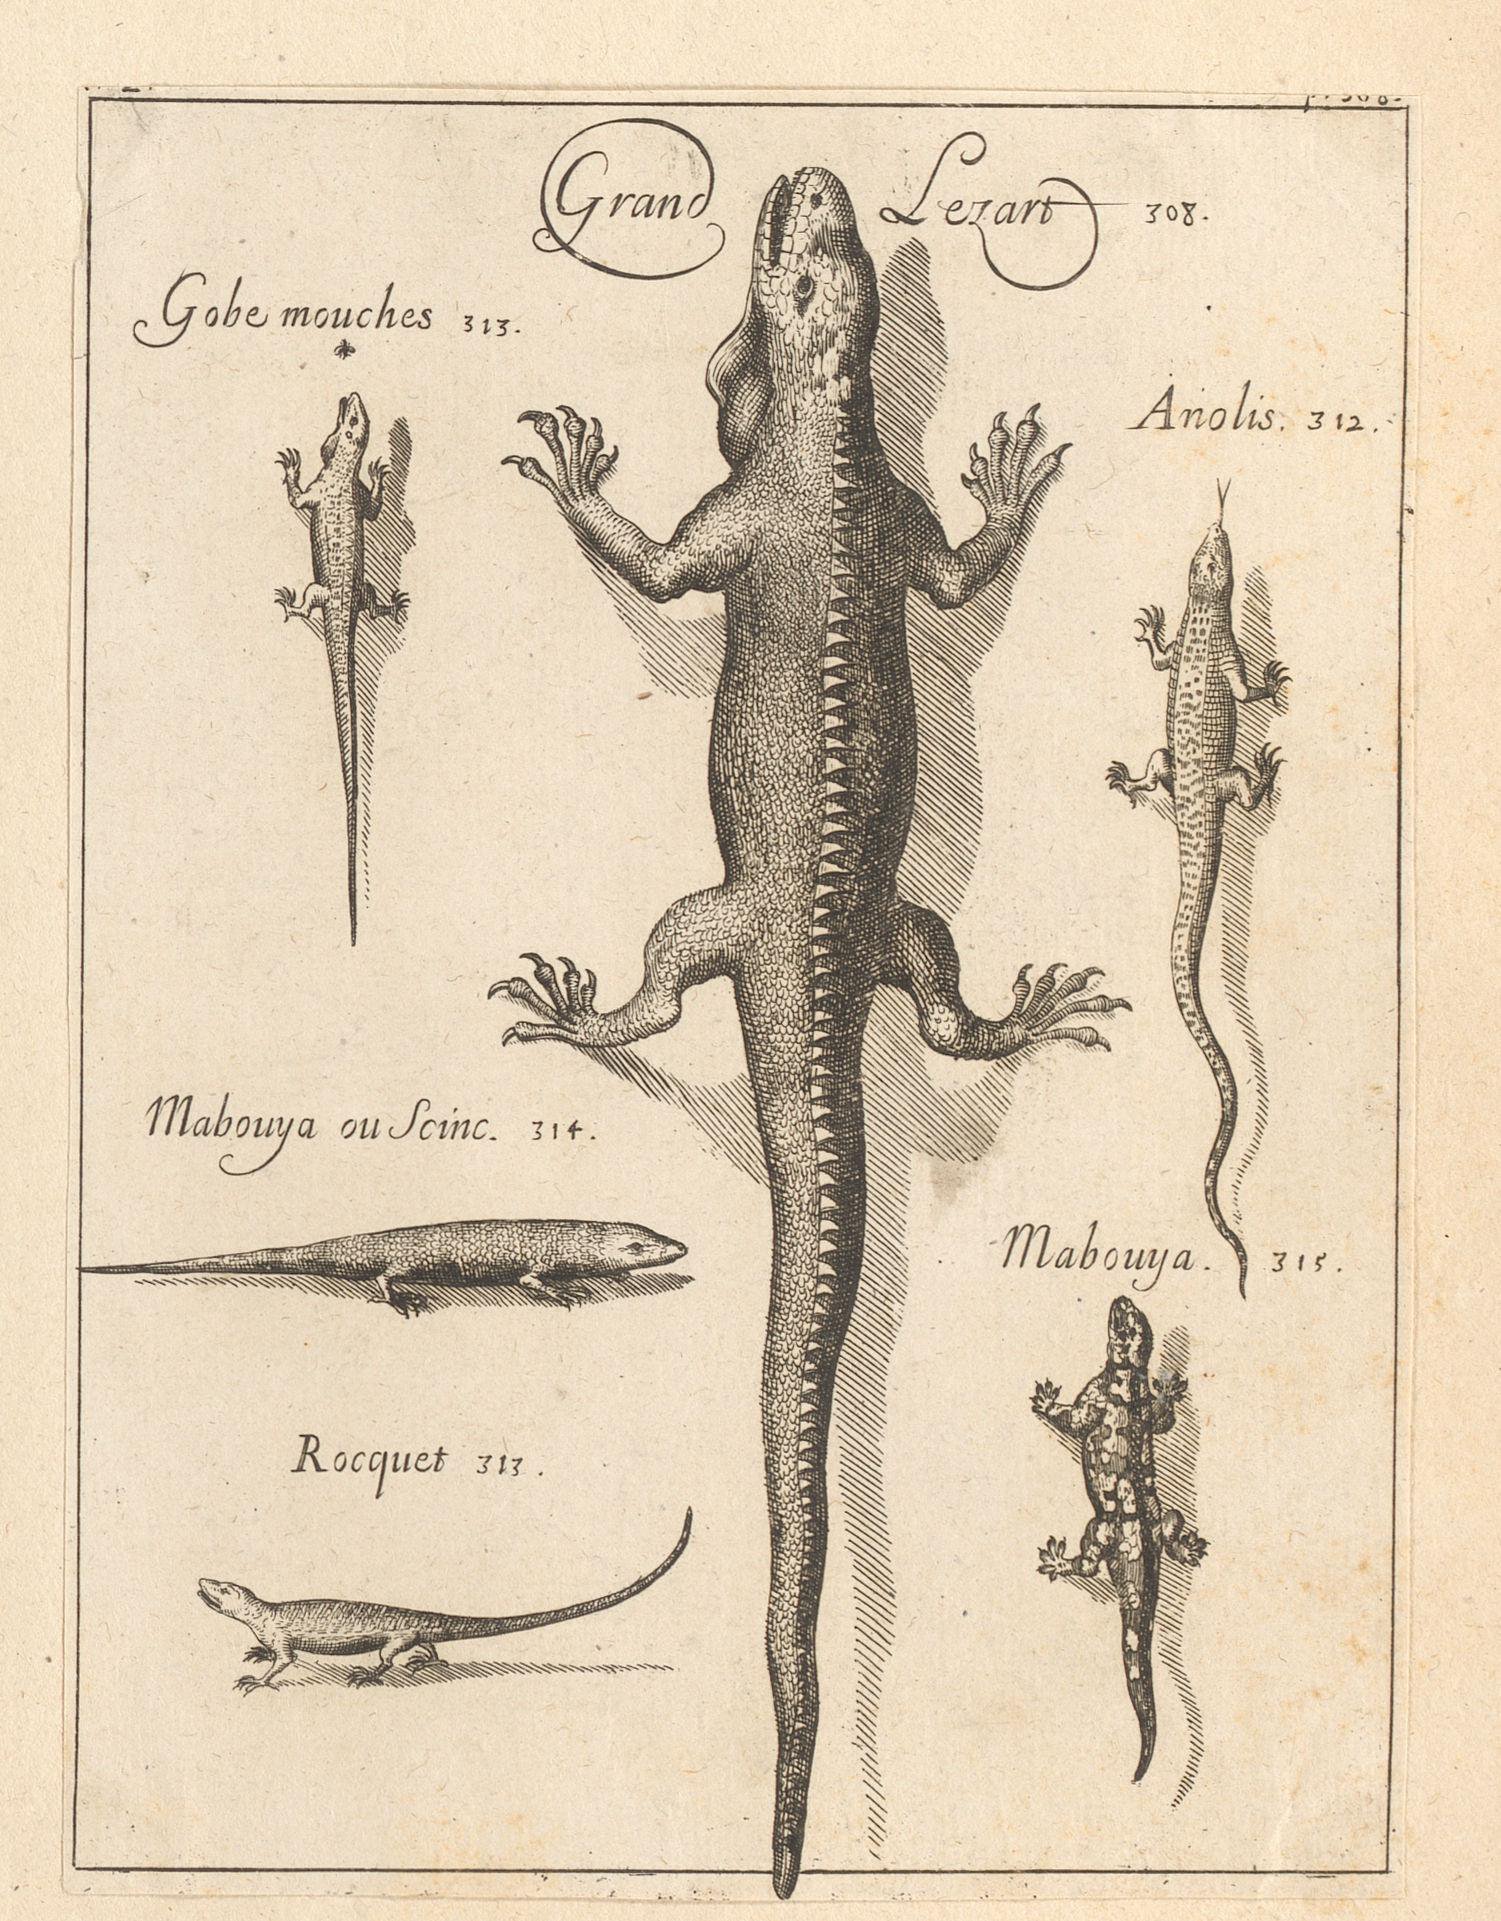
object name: print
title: Verschillende hagedissen van de Franse Antillen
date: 1667-1671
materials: paper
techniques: etching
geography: paris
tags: lizards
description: Prent uit: Du Tertre, Jean-Baptiste. Histoire generale des Antilles habitées par les François (...). Parijs: Thomas Jolly 1667-1671.